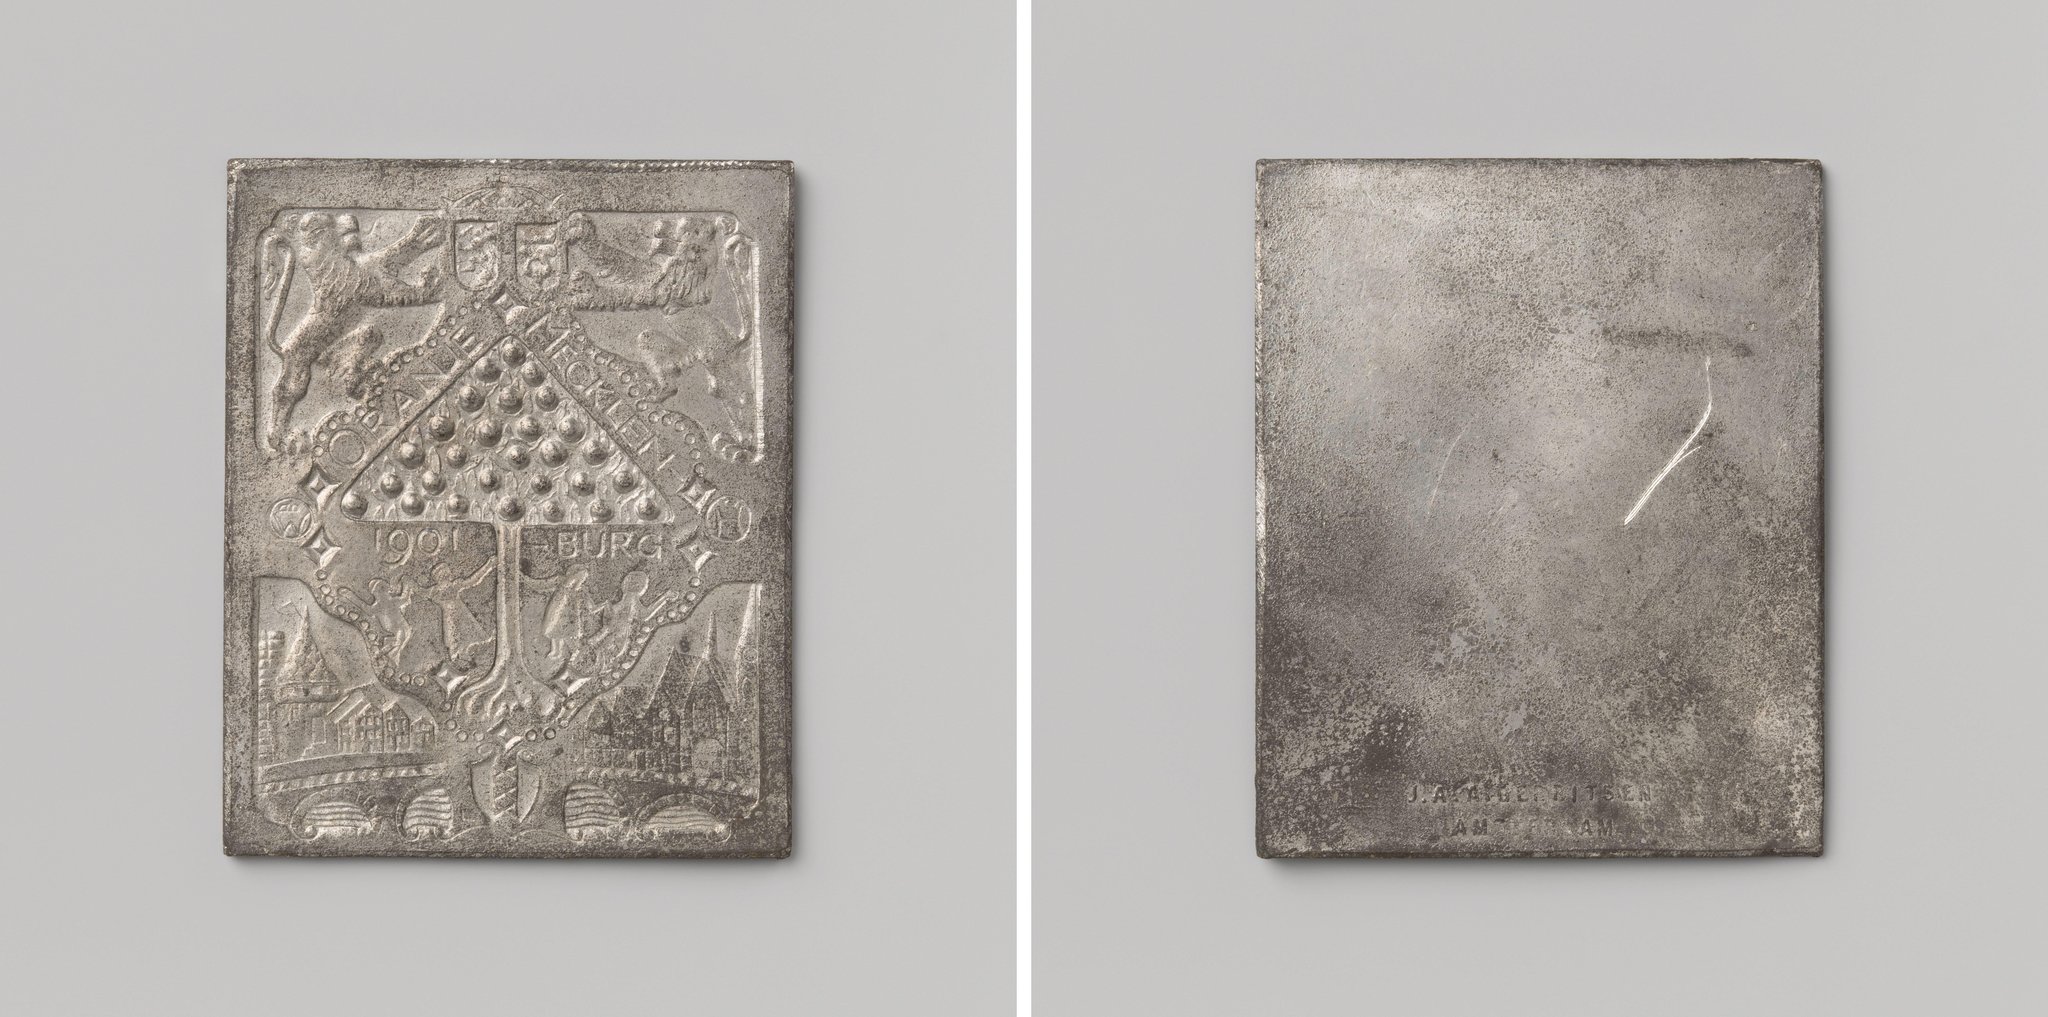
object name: plaque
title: Huwelijk van Wilhelmina en Hendrik, koningin en prins der Nederlanden, plaquette uitgedeeld aan leerlingen van Amsterdamse lagere scholen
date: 1901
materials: tin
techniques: striking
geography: amsterdam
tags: the hague, print maker, wilhelmina of the netherlands, hendrik (prins der nederlanden (1876-1934))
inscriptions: circumscription: ‘ORANJE MECKLBURG 1901’